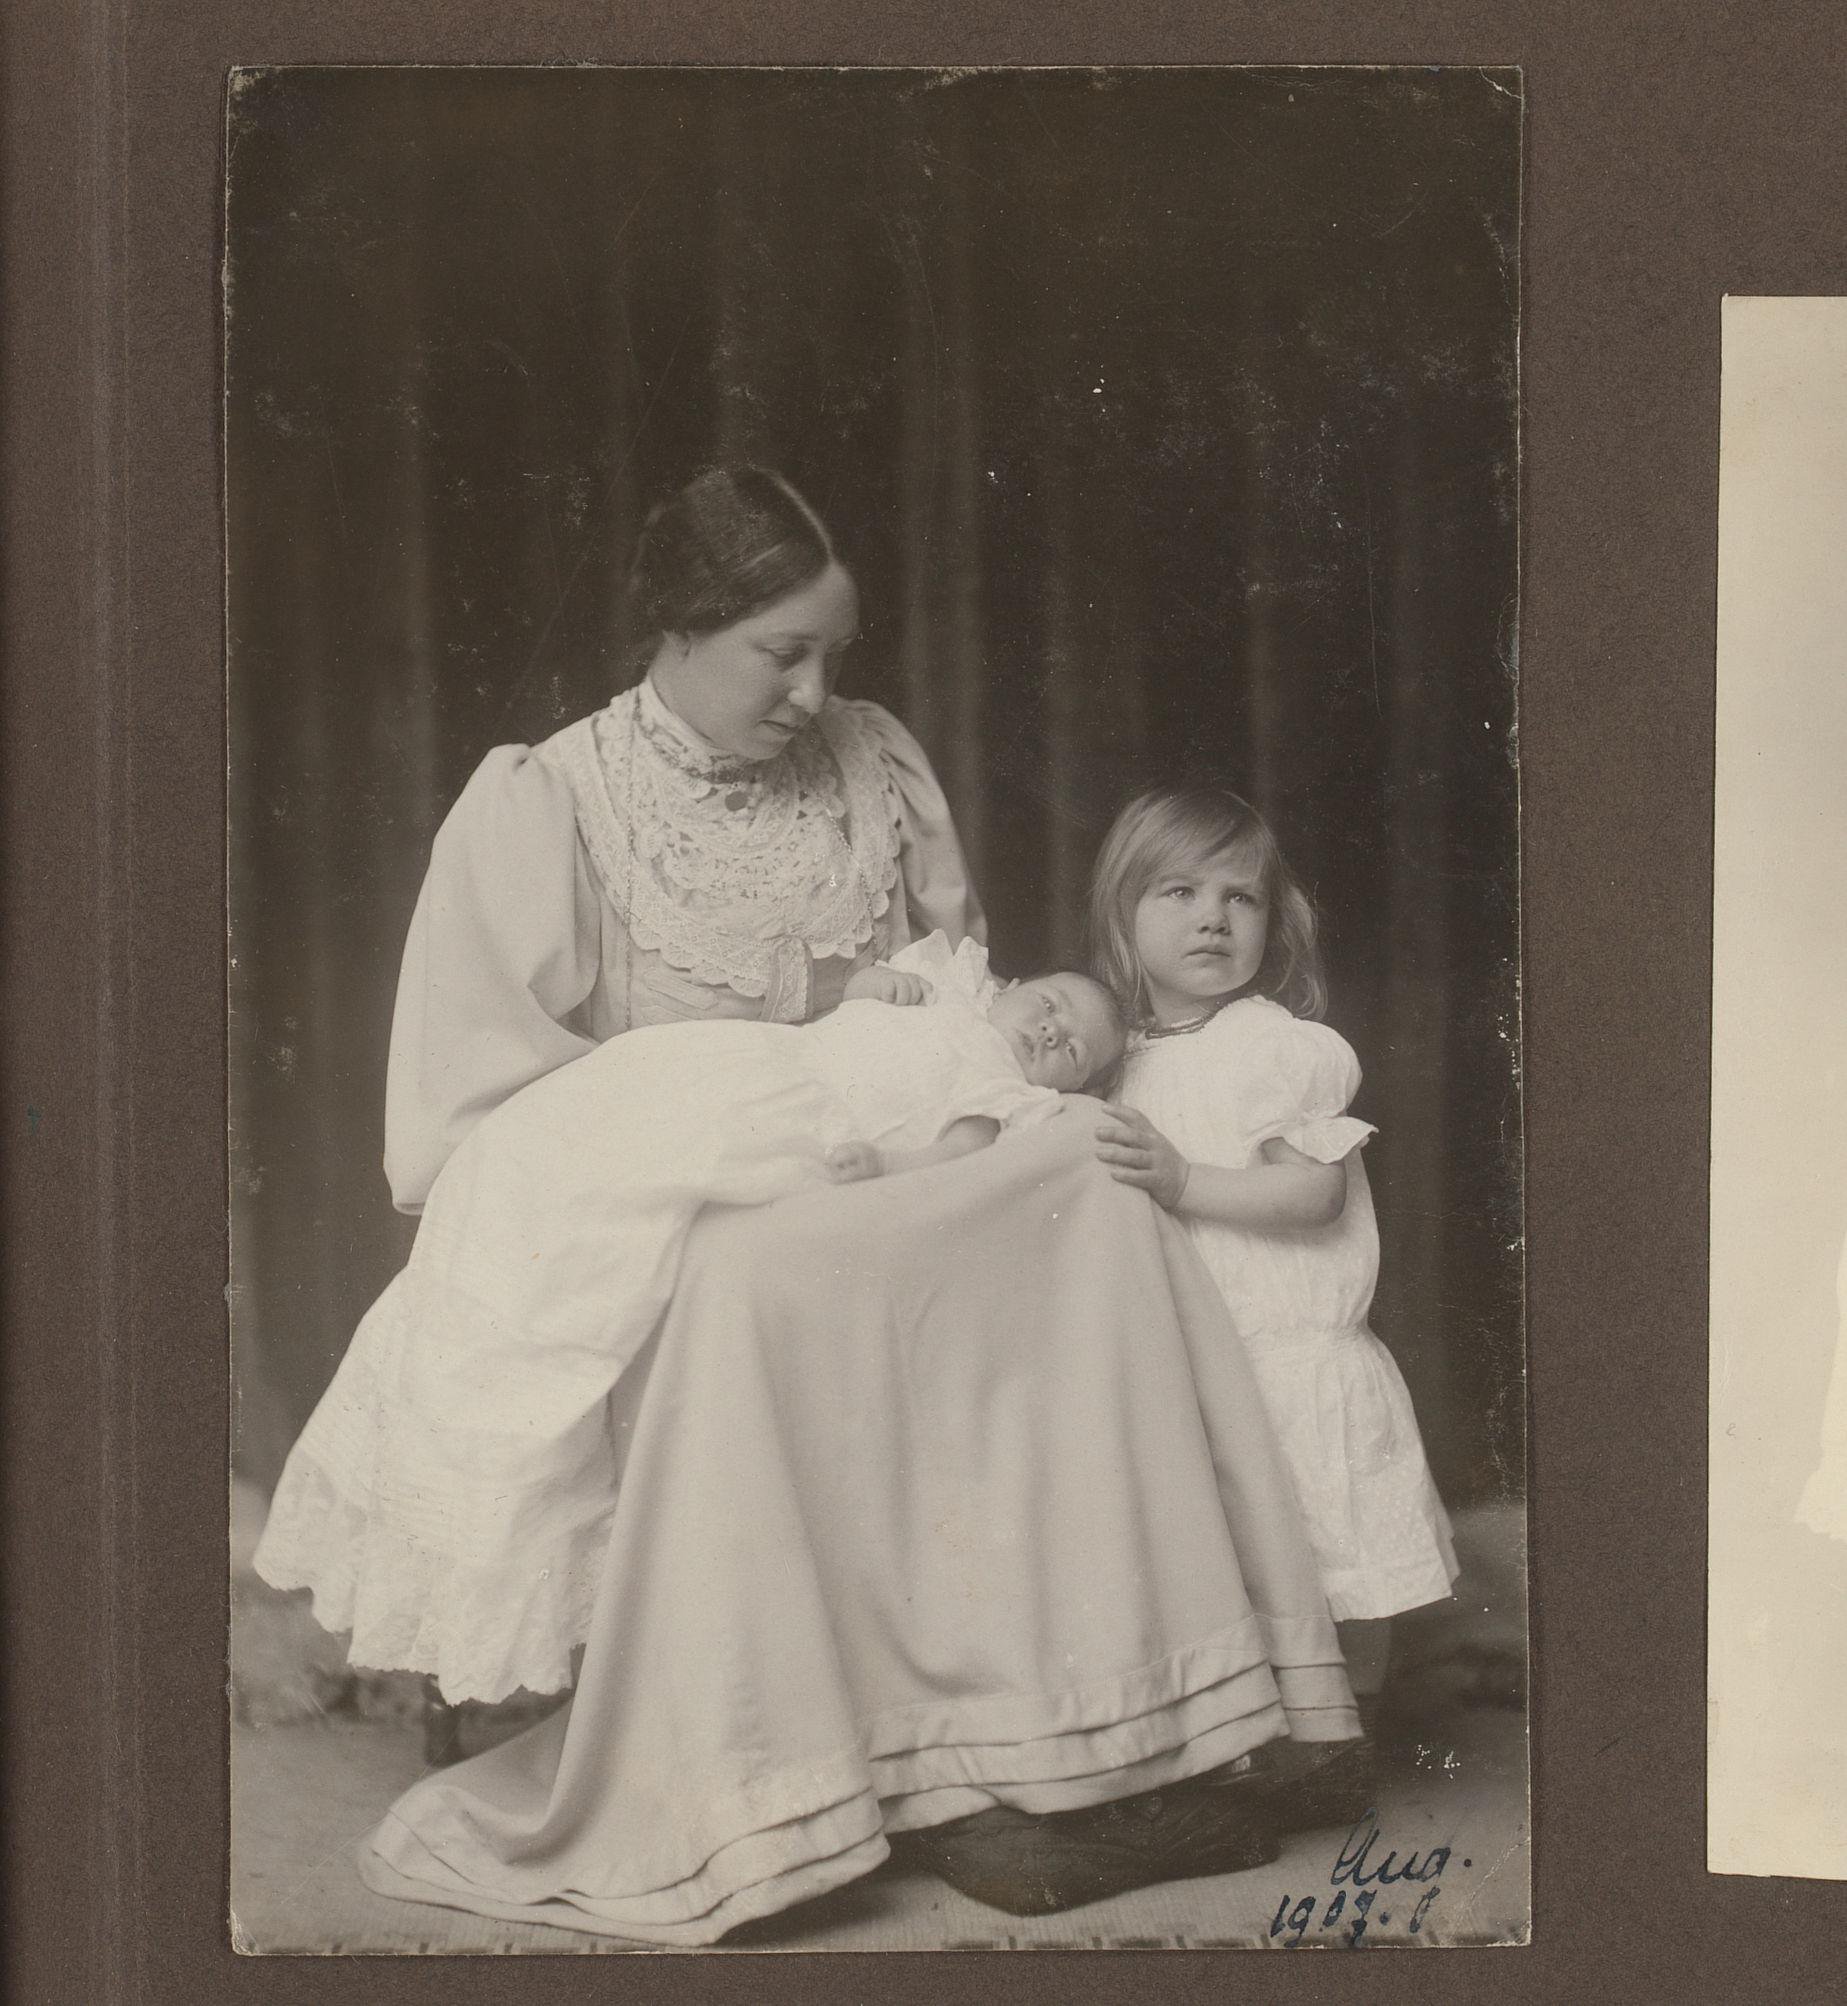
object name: photograph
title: Portret van Elsa Diepenbrock met Thea op schoot in een doopjurk en Joanna staand ernaast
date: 1907-1908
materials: paper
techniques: gelatin silver print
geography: netherlands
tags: jonkvrouw wilhelmina elisabeth petronella cornelia de jong van beek en donk, mother with daughter(s) (mother-love), historical persons - bb - woman, baptism, christening gown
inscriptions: date: ‘Aug./ 1907.’